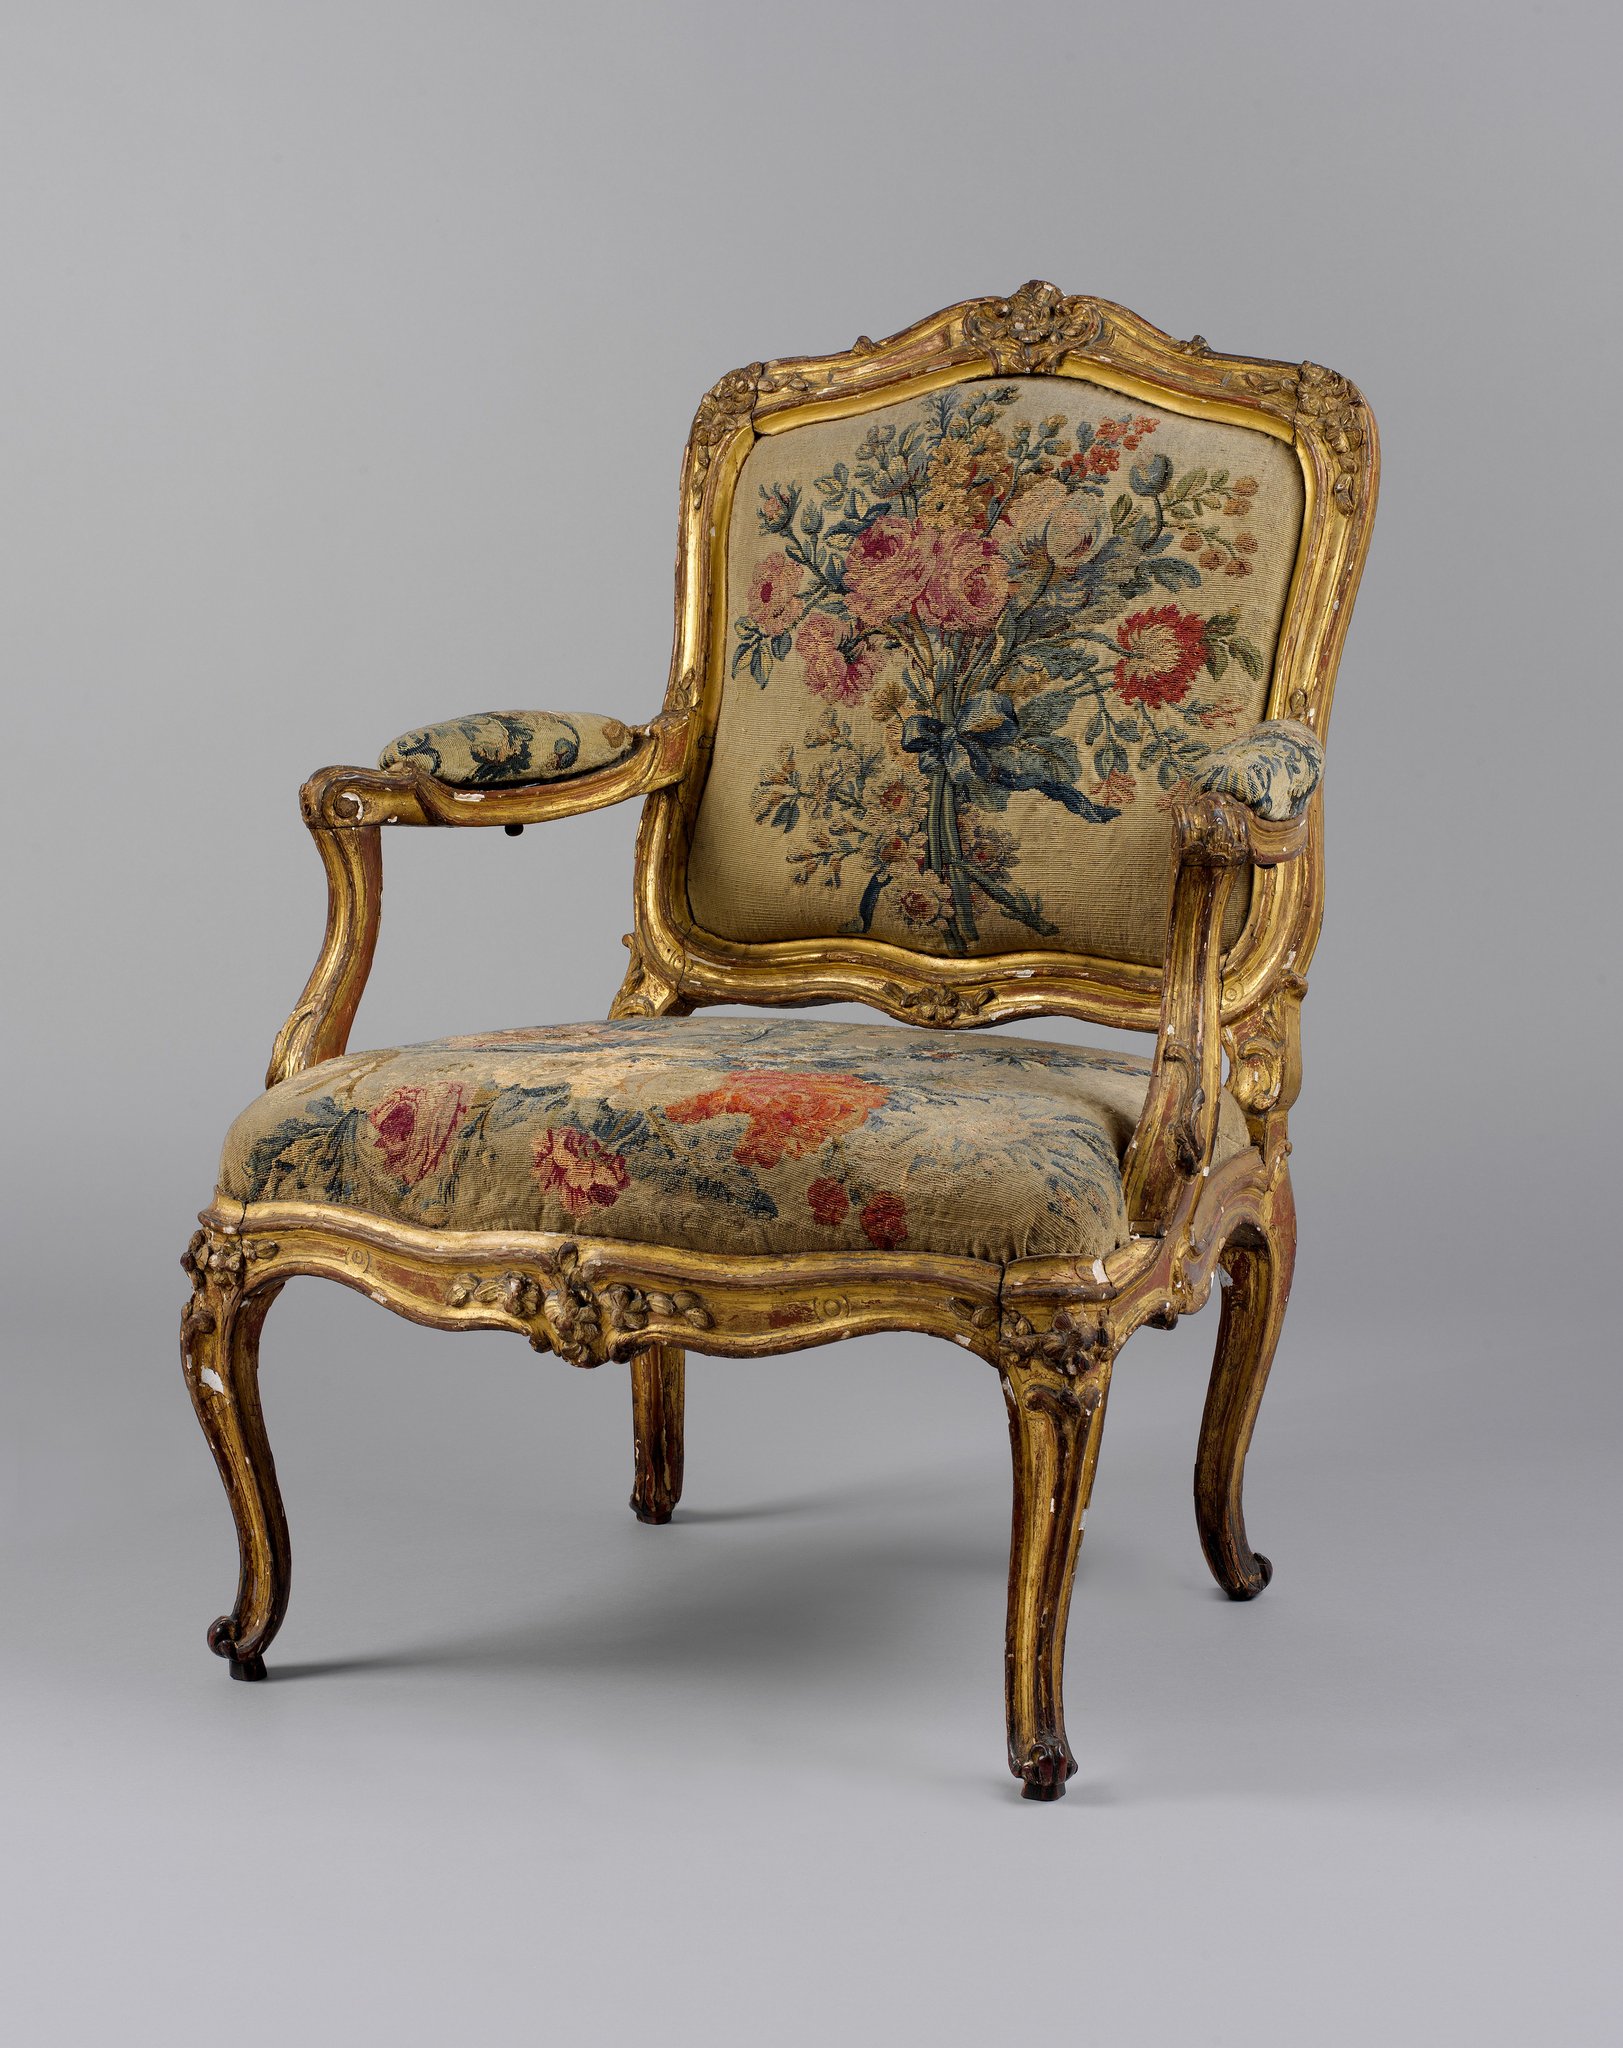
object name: armchair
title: Armchair (fauteuil)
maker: beauvais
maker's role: factory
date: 1701-1750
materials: wood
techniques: carving, gilding, tapestry